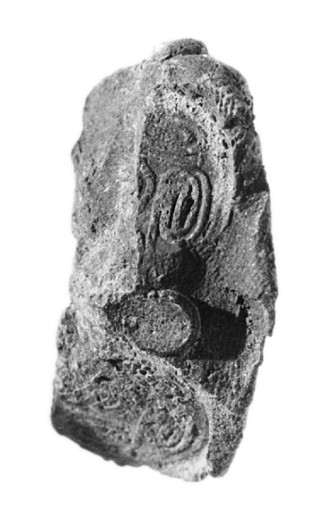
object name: sealing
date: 1981-1640 BCE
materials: mud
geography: egypt